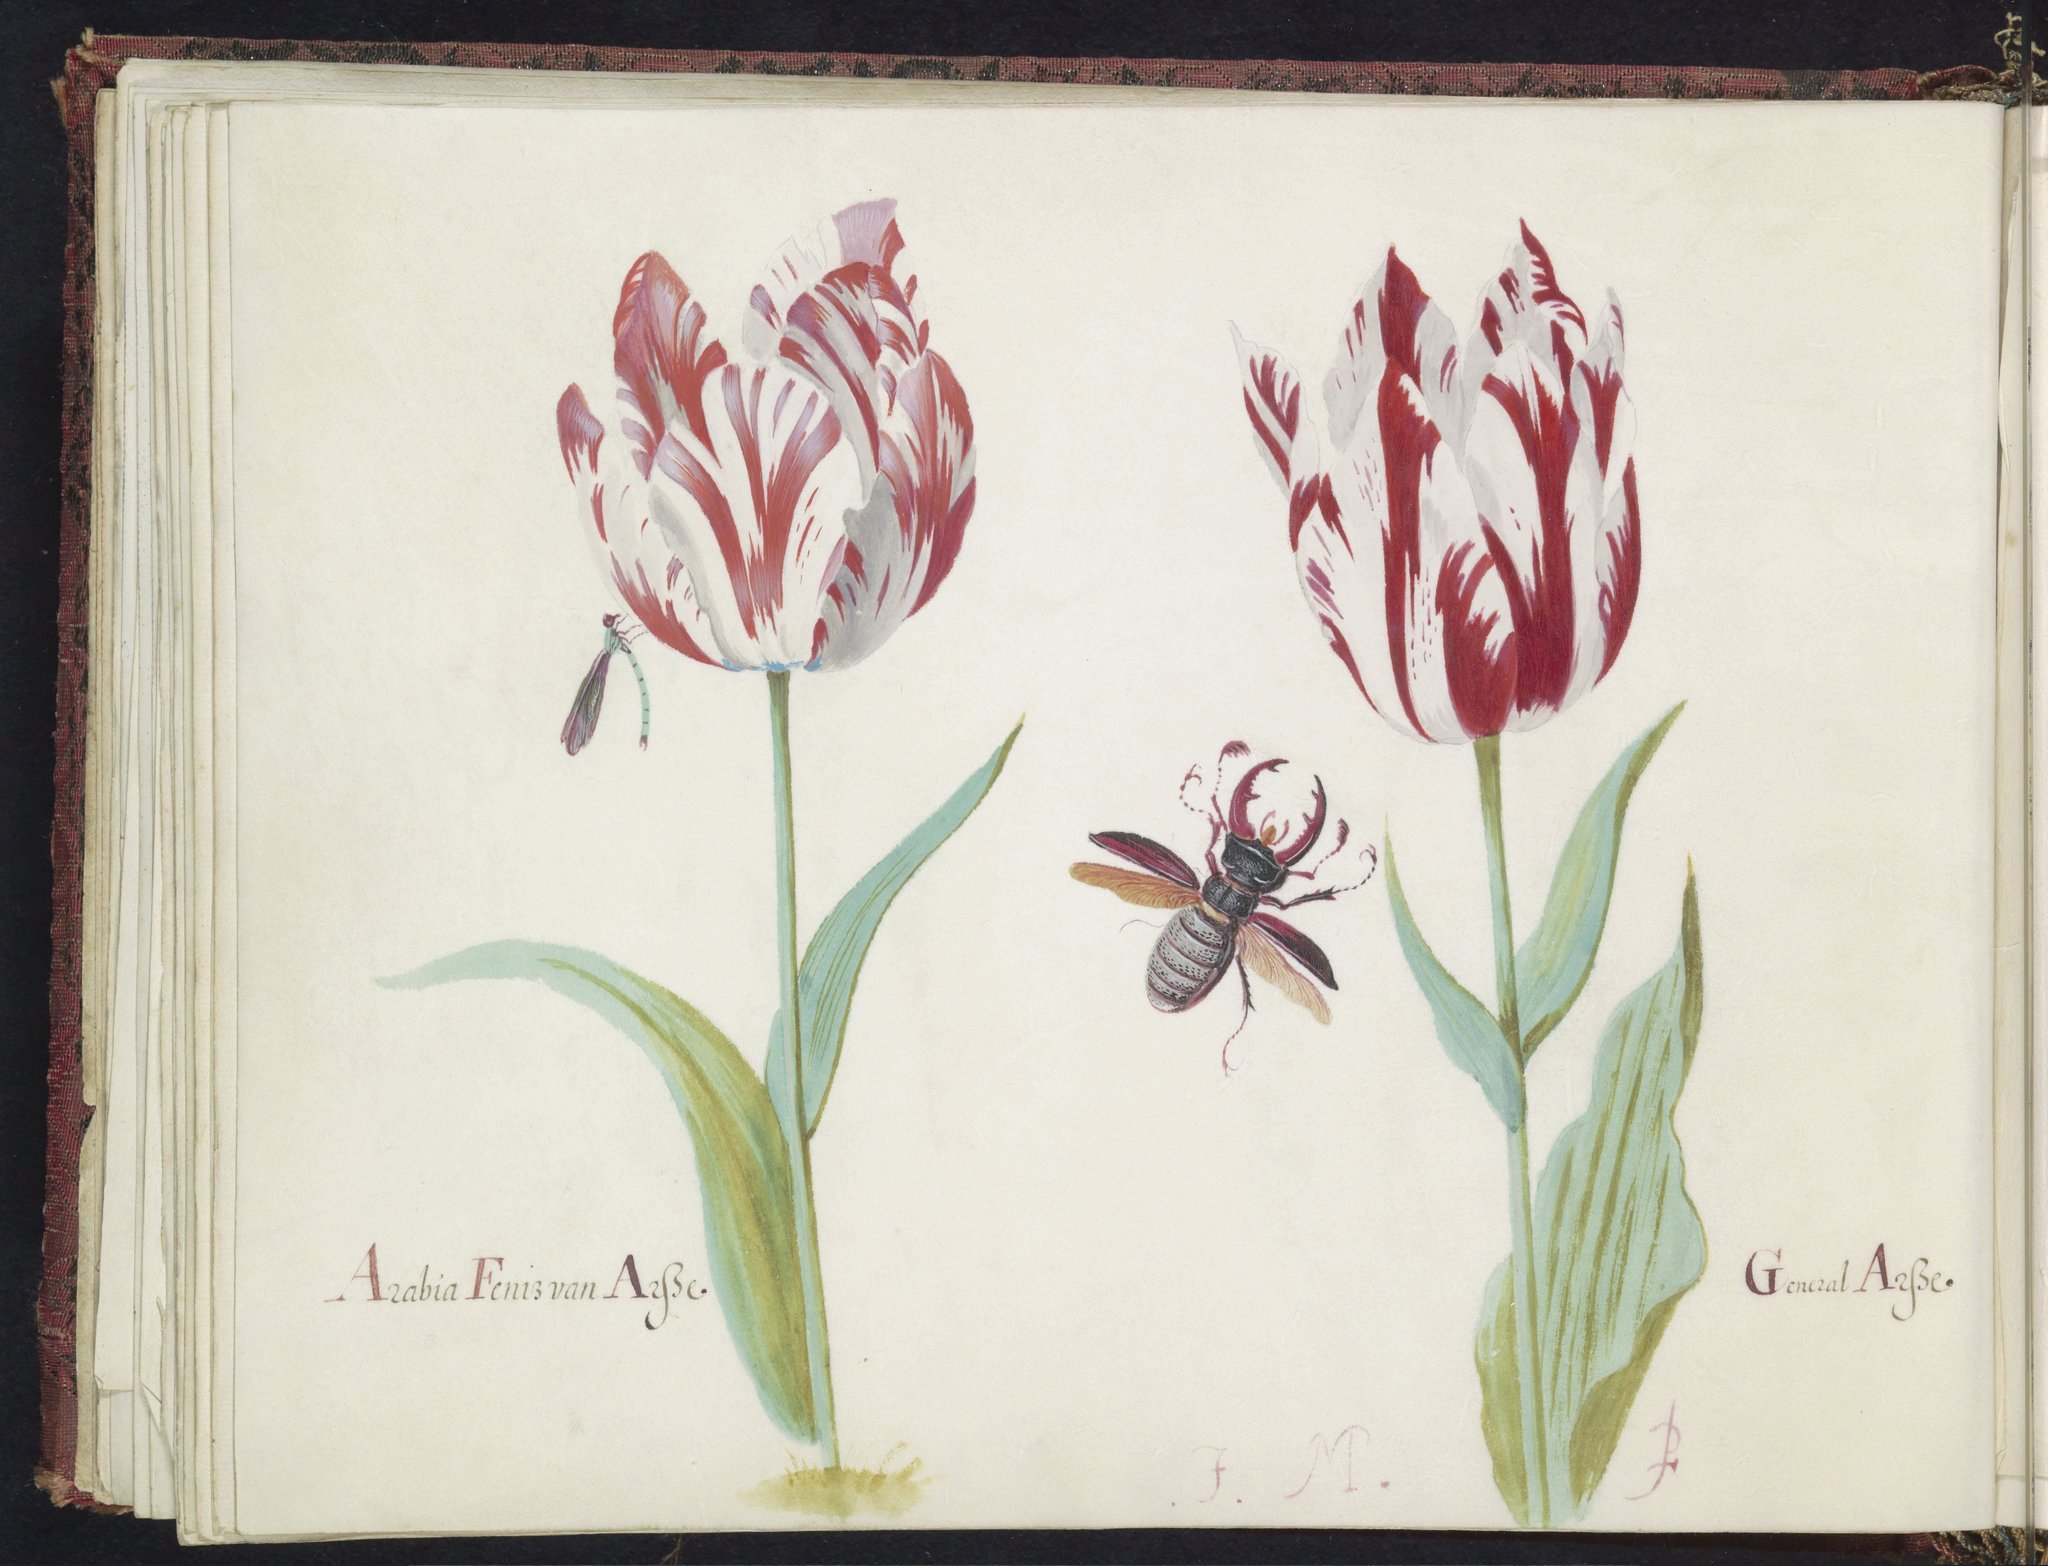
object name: drawing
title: Arabia Fenis van Arsse / General Arsse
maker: jacob marrel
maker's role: draughtsman, painter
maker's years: 1614-1681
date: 1637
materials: paint, parchment, pencil, watercolor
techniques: brush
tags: flowers: tulip, insects: beetle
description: De tekening maakt deel uit van een album.